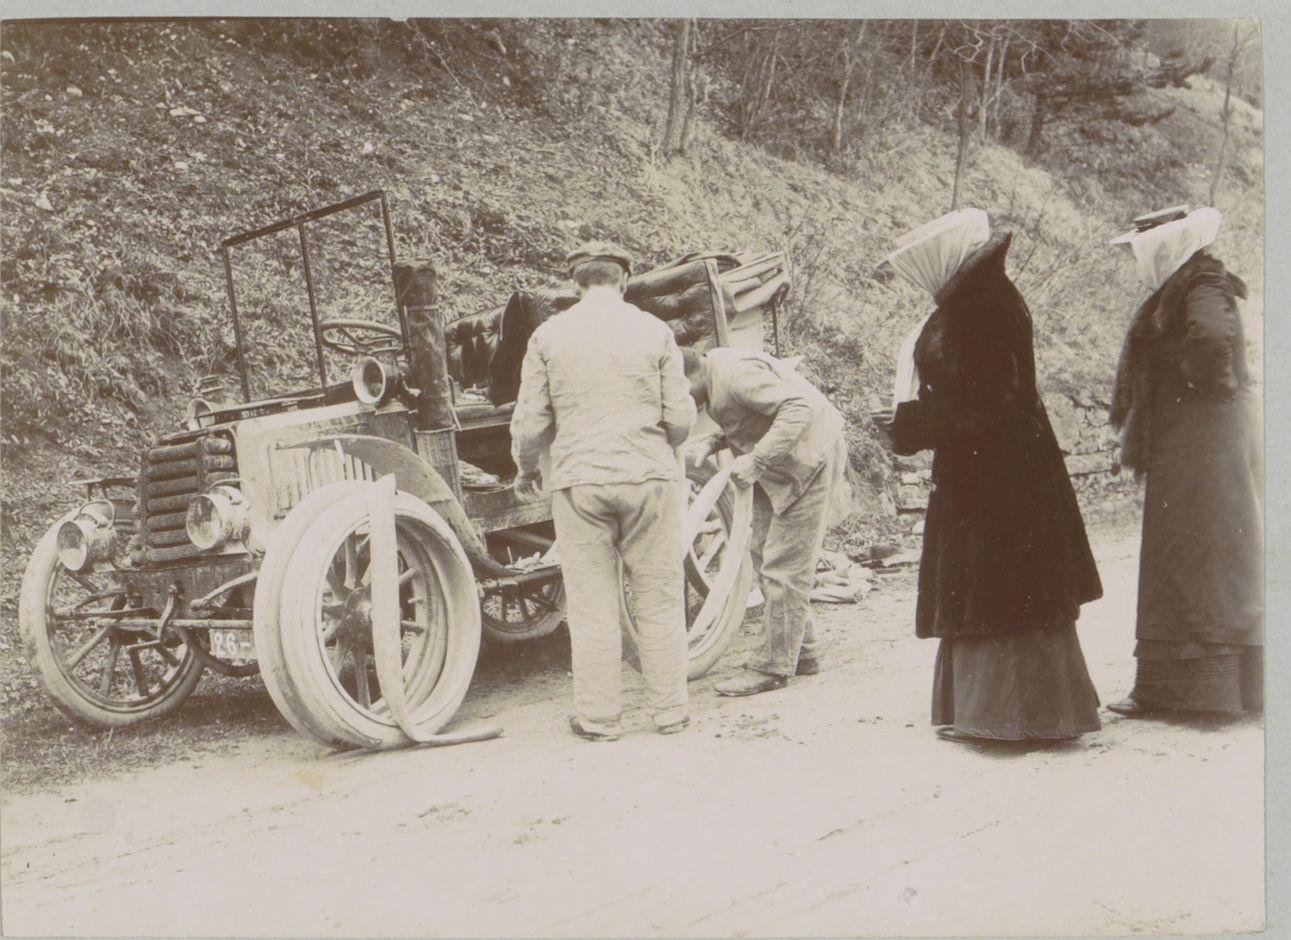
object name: photograph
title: Gezelschap kijkt toe bij bandenwissel van automobiel, vermoedelijk in de Franse Alpen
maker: delizy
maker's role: manufacturer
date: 1903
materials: paper, photographic support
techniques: gelatin silver print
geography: alps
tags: maintenance, repair, storage ~ motor vehicles, automobile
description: Onderdeel van Fotoalbum van een Franse amateurfotograaf met opnames van uitstapjes in Frankrijk, Spanje, België, Luxemburg en Nederland, de eerste automobielen en autoraces.